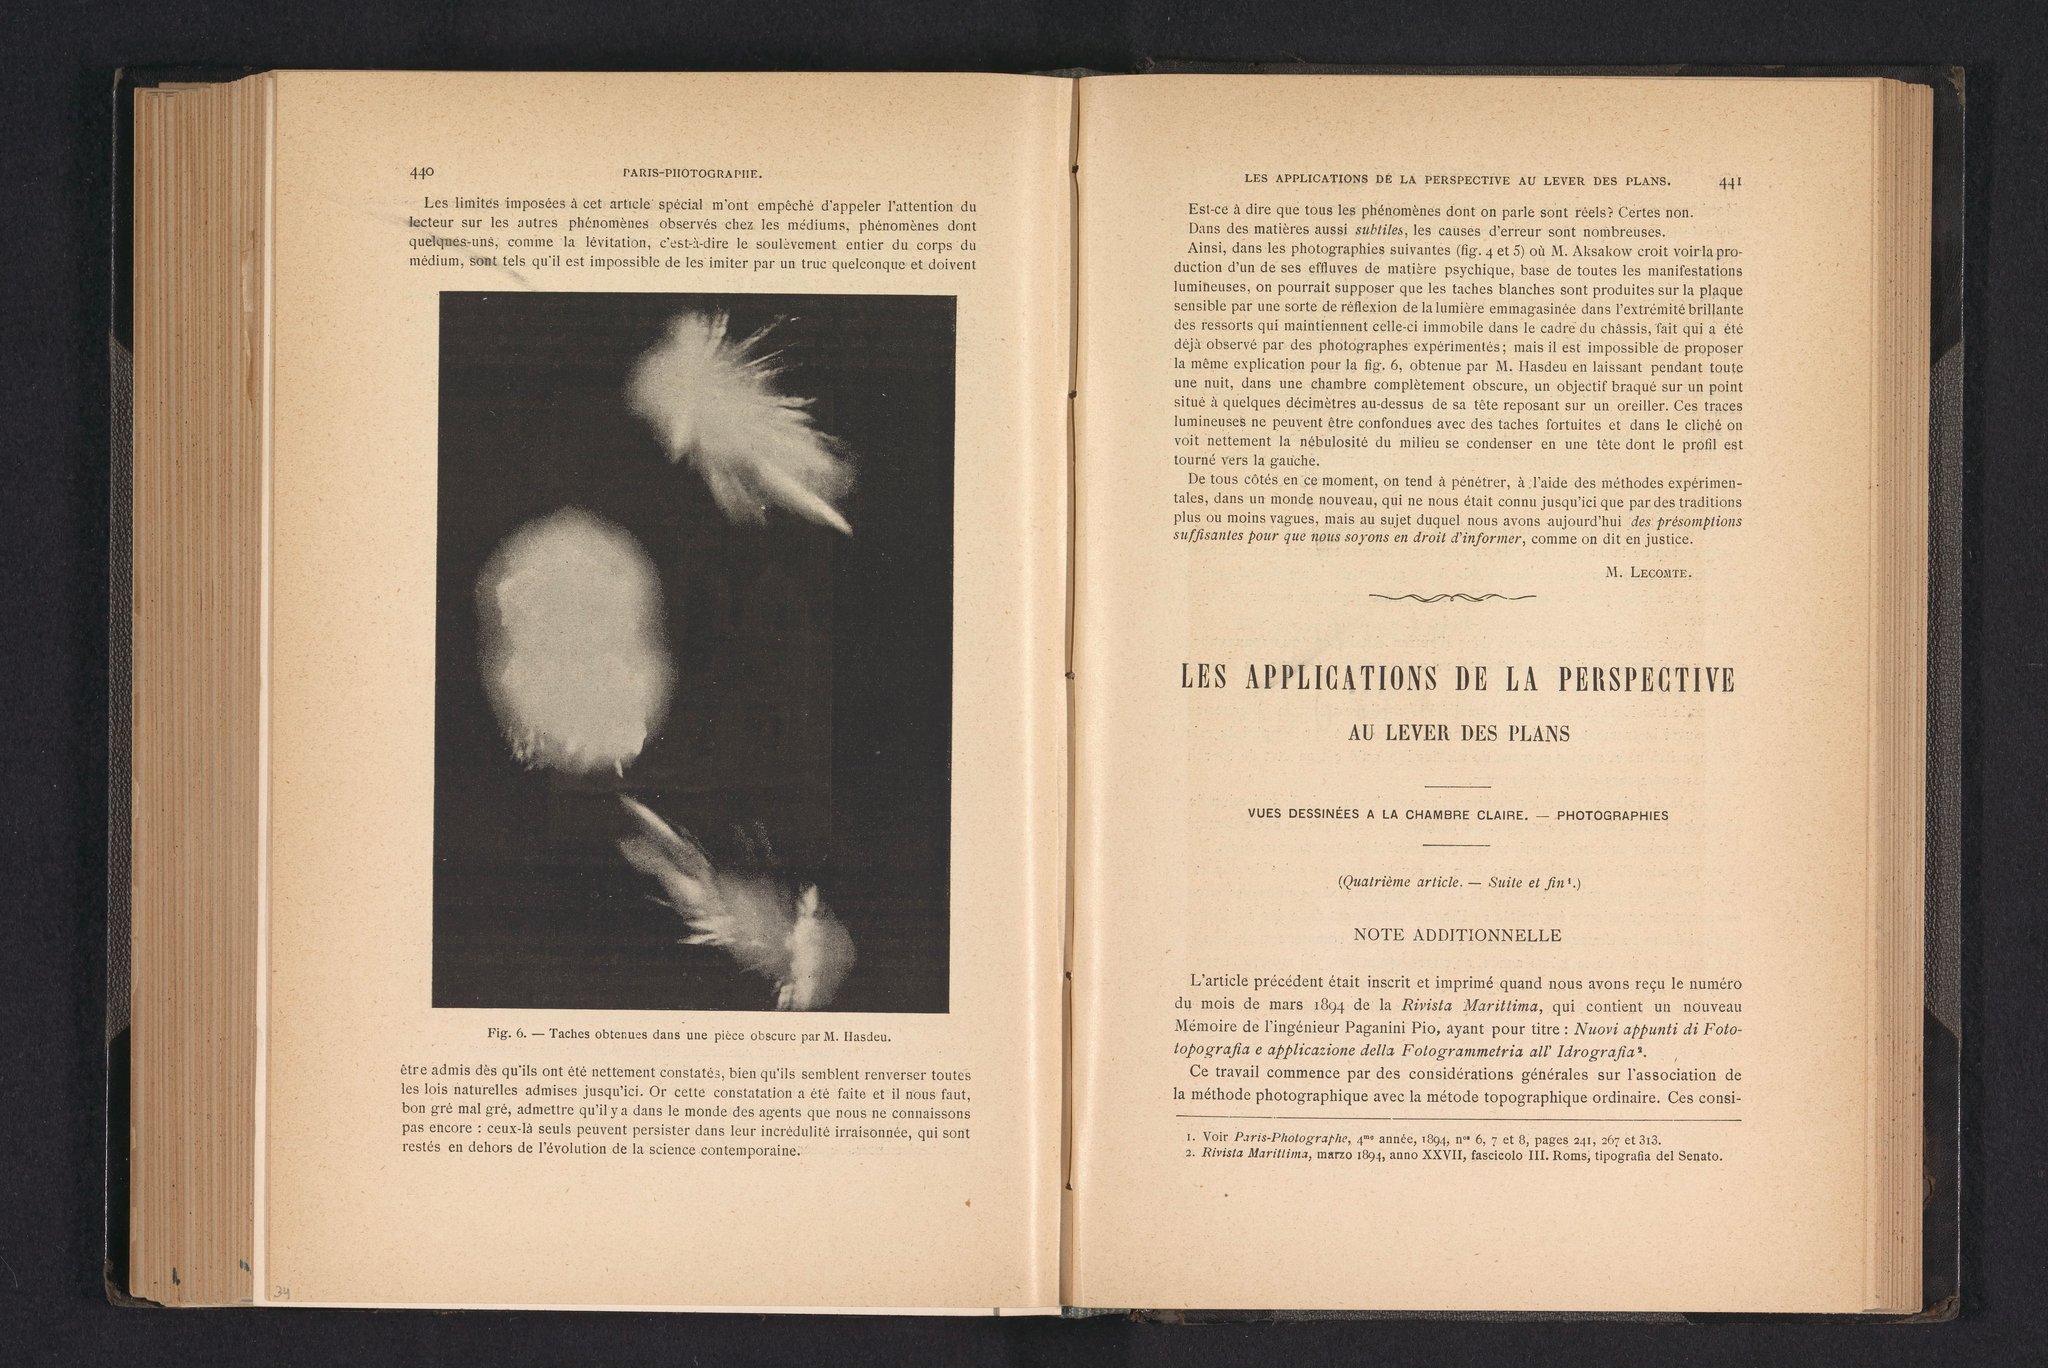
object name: photomechanical print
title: Taches obtenues dans un pièce obscure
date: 1884-1894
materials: paper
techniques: autotype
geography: europe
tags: light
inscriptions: number: ‘Fig. 6.’